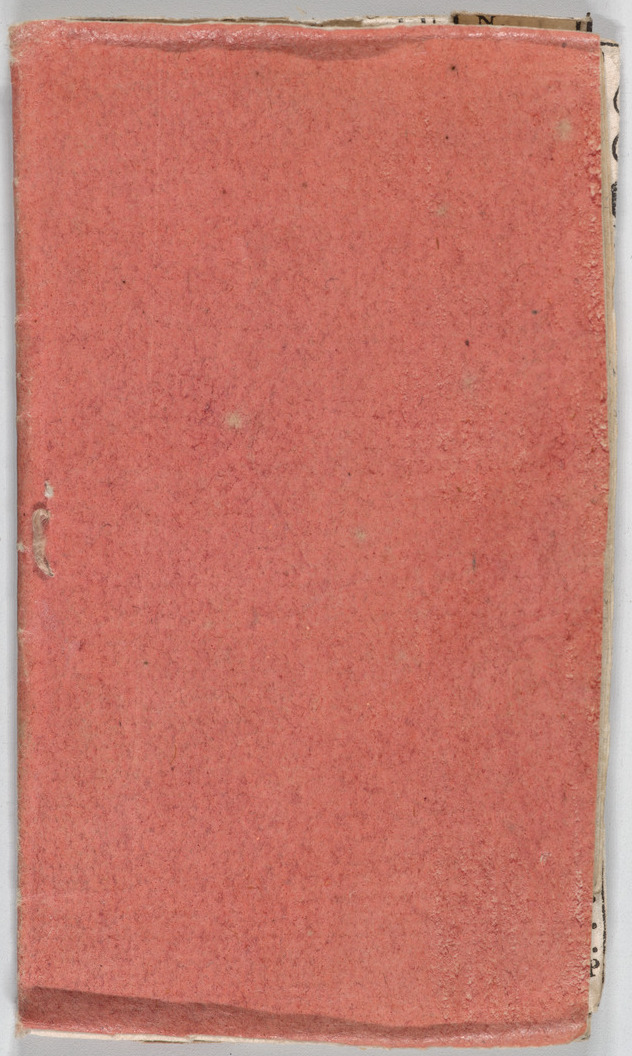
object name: print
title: Instruction manual for playing cards "Jeu d'Or"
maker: anonymous, french, 18th century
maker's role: artist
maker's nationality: french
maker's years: 1700-1800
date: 1700-1799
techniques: etching, hand coloring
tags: abstraction